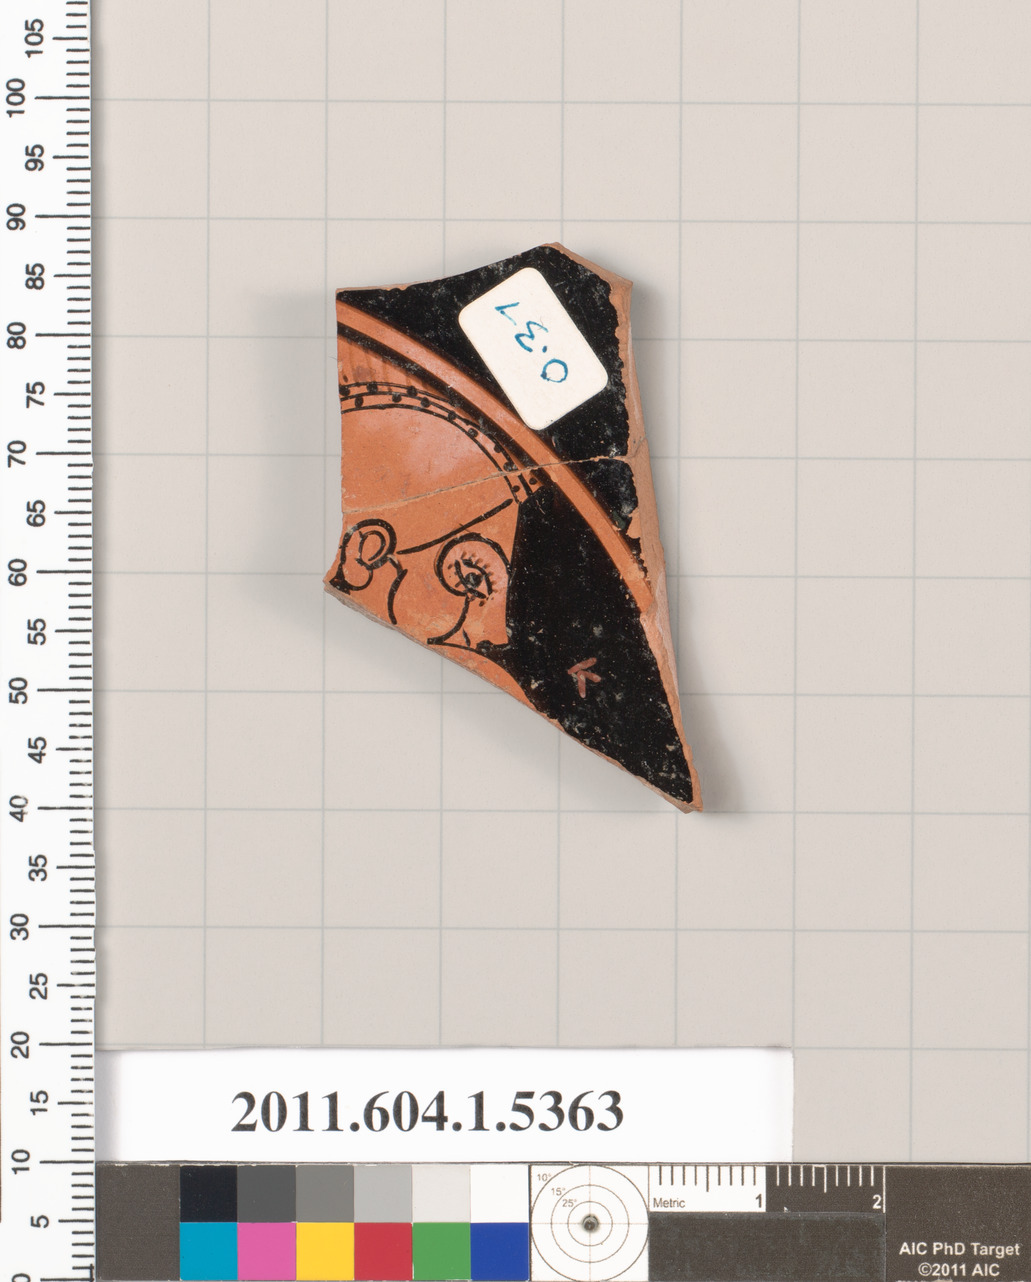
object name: kylix fragment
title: Terracotta fragment of a kylix (drinking cup)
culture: greek, attic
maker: nicosthenic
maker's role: artist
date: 510-500 BCE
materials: terracotta